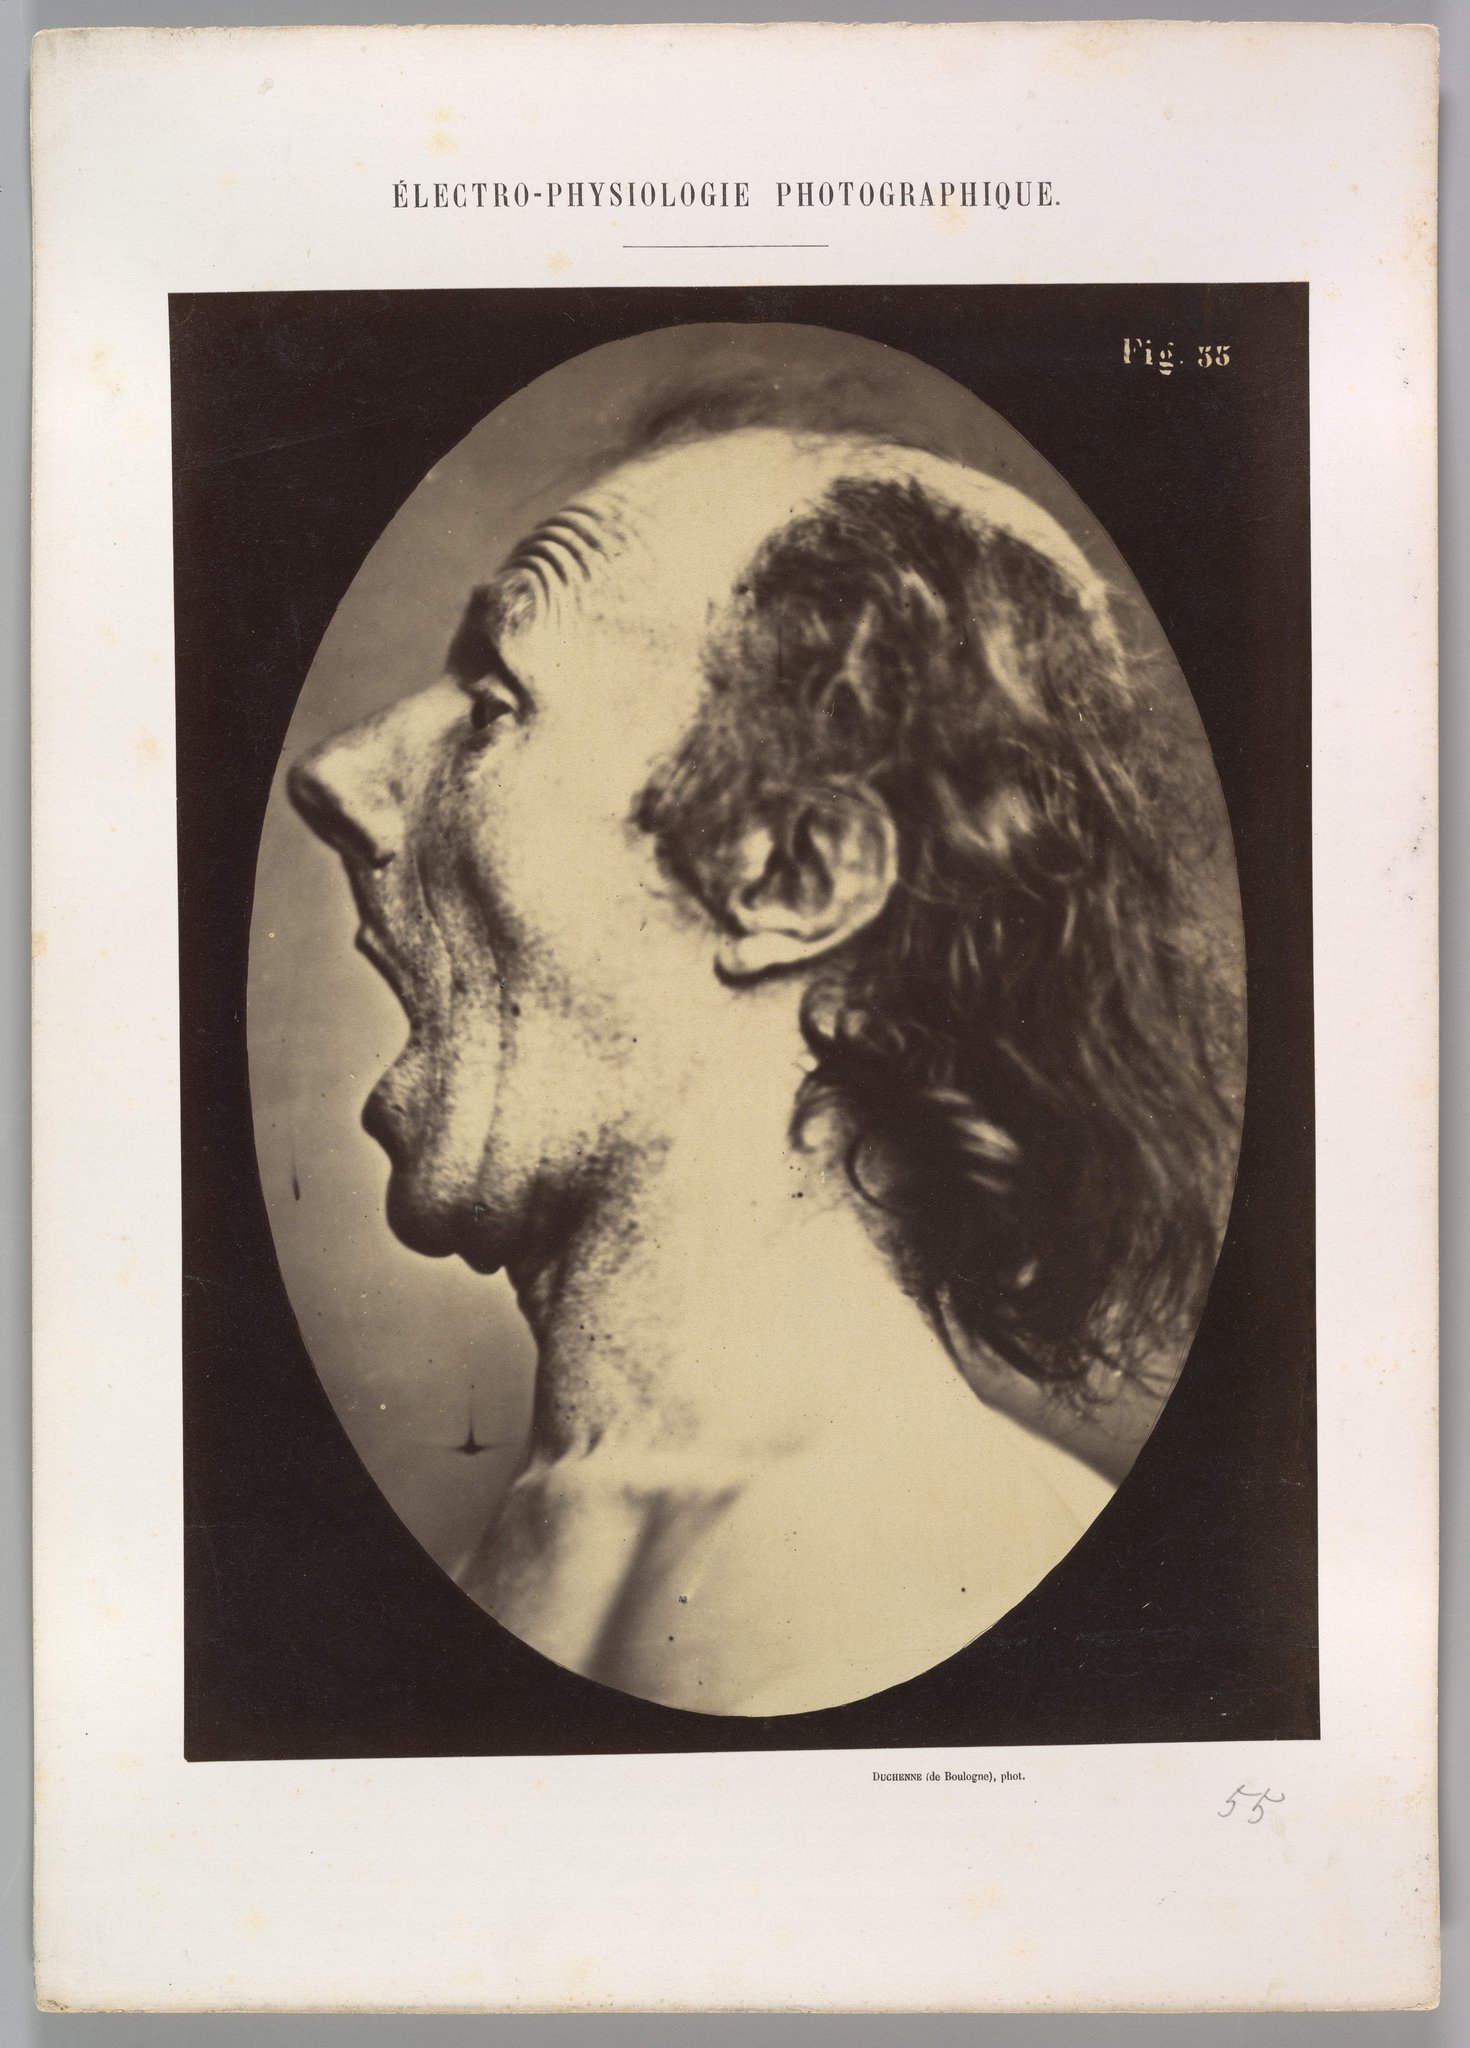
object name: photograph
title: Figure 55: Astonishment badly rendered by the subject: a ridiculous and inane expression.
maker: guillaume-benjamin-amand duchenne de boulogne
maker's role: artist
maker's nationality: french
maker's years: 1806-1875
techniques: albumen silver print, glass negative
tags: science,men,portraits